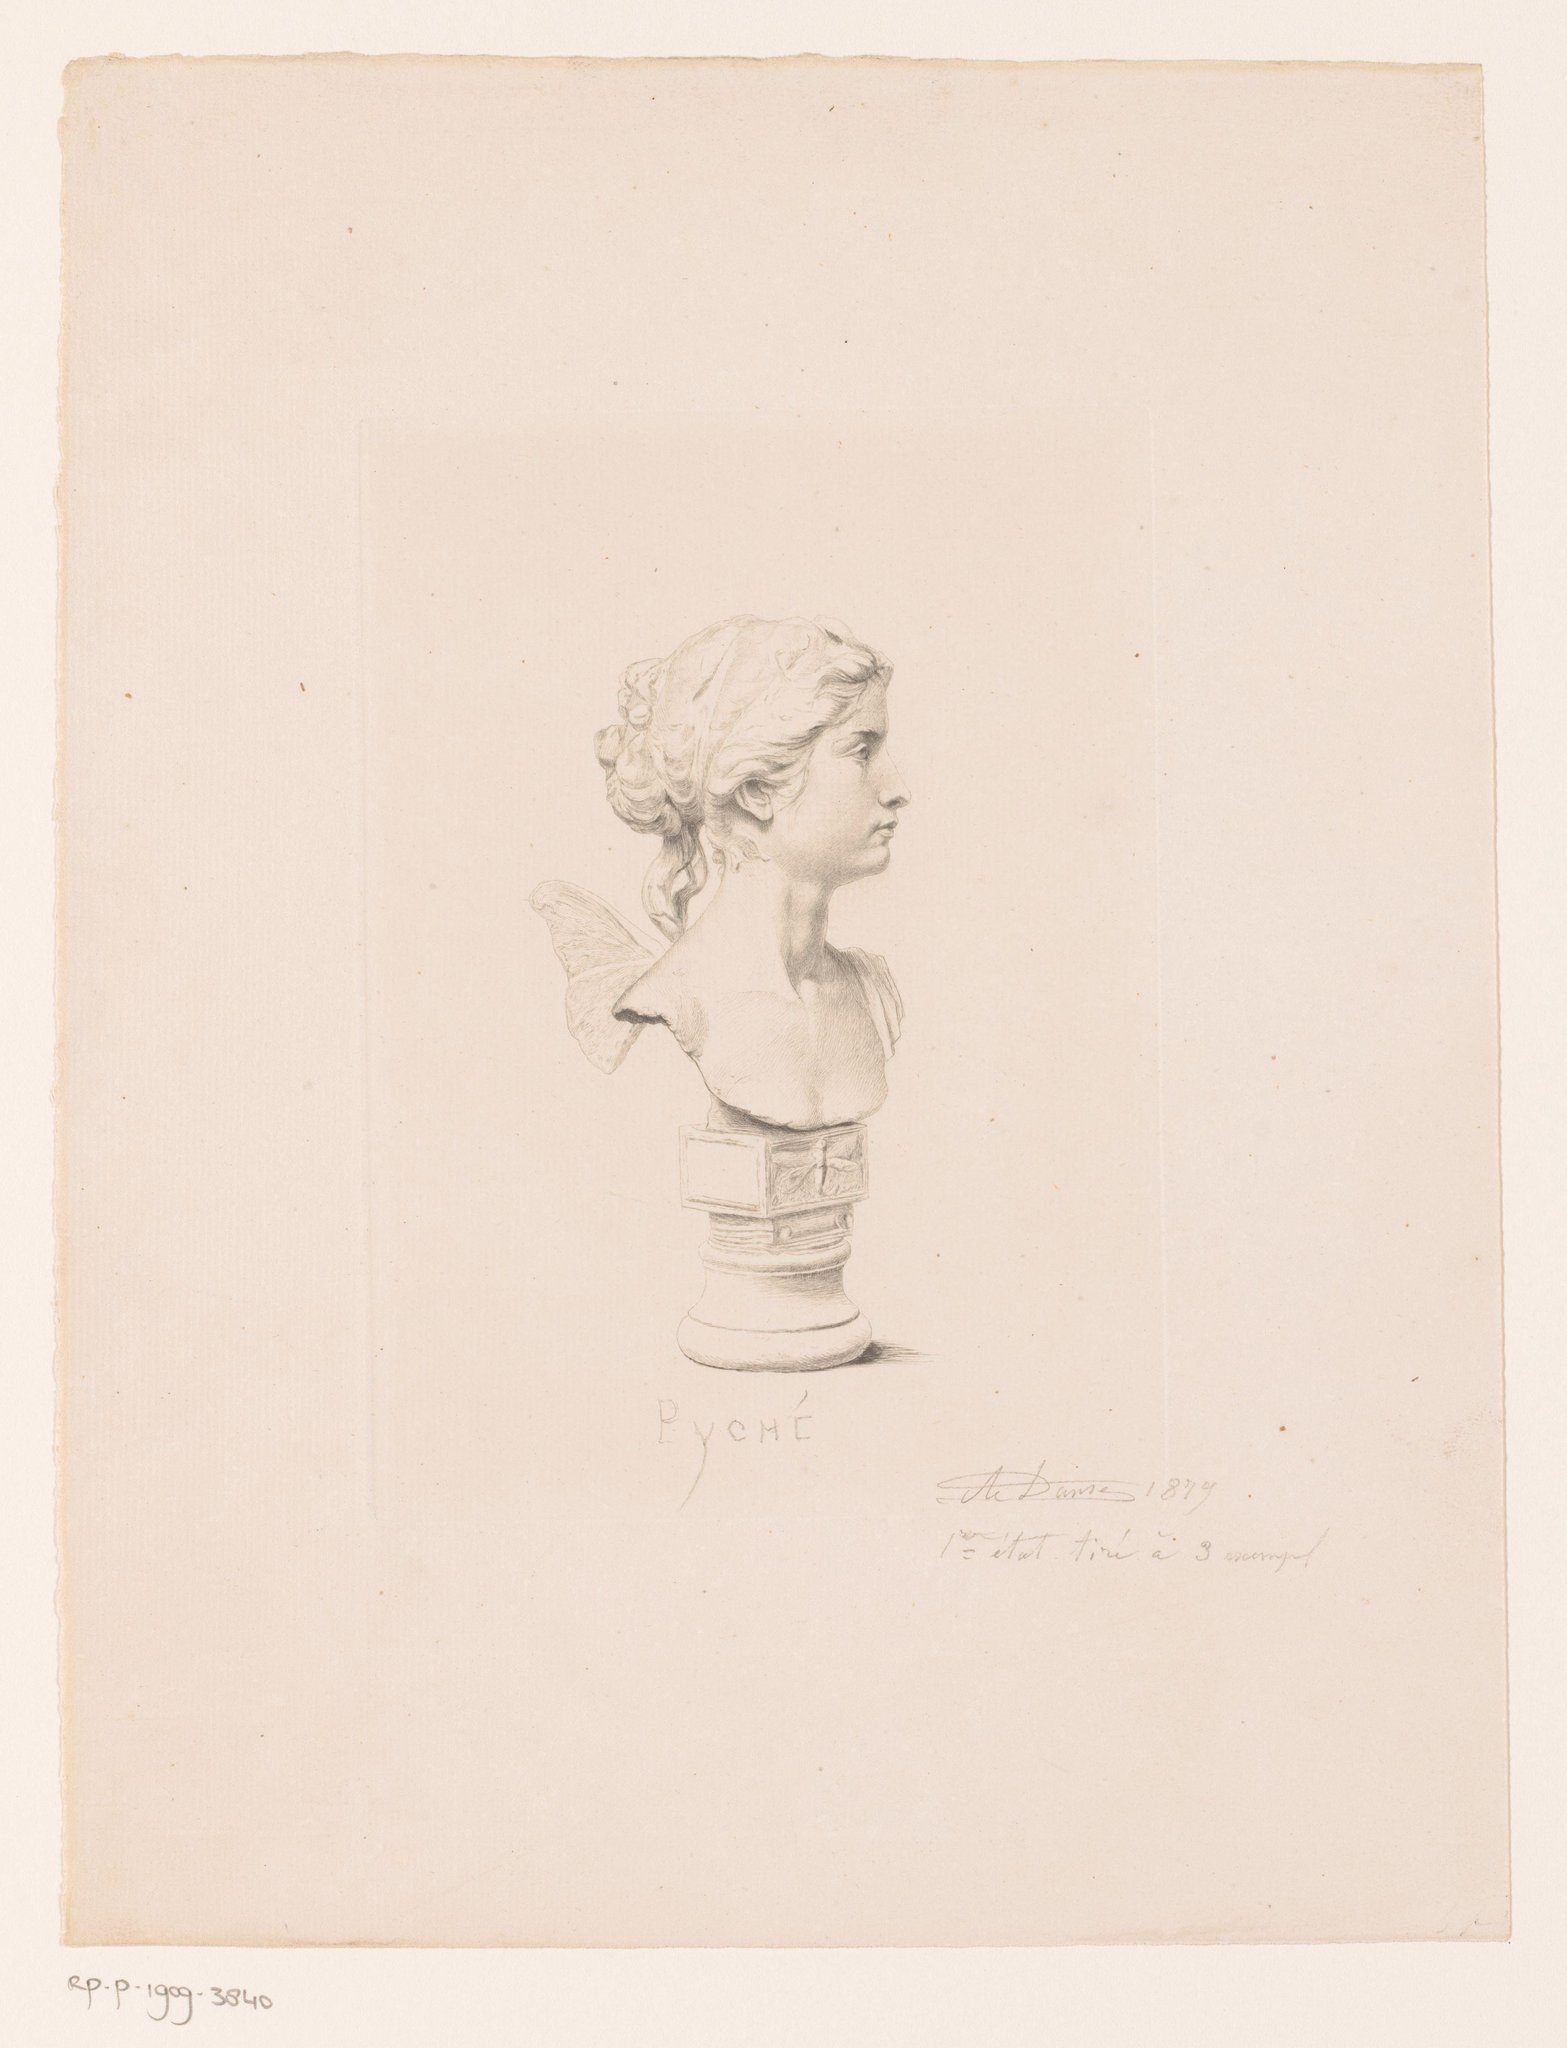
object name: print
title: Buste van Psyche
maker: auguste danse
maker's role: print maker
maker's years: 1829-1929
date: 1879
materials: paper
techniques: etching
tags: psyche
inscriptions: collector's mark: Lugt 2228, annotation: ‘1er état tiré à 3 exempl’